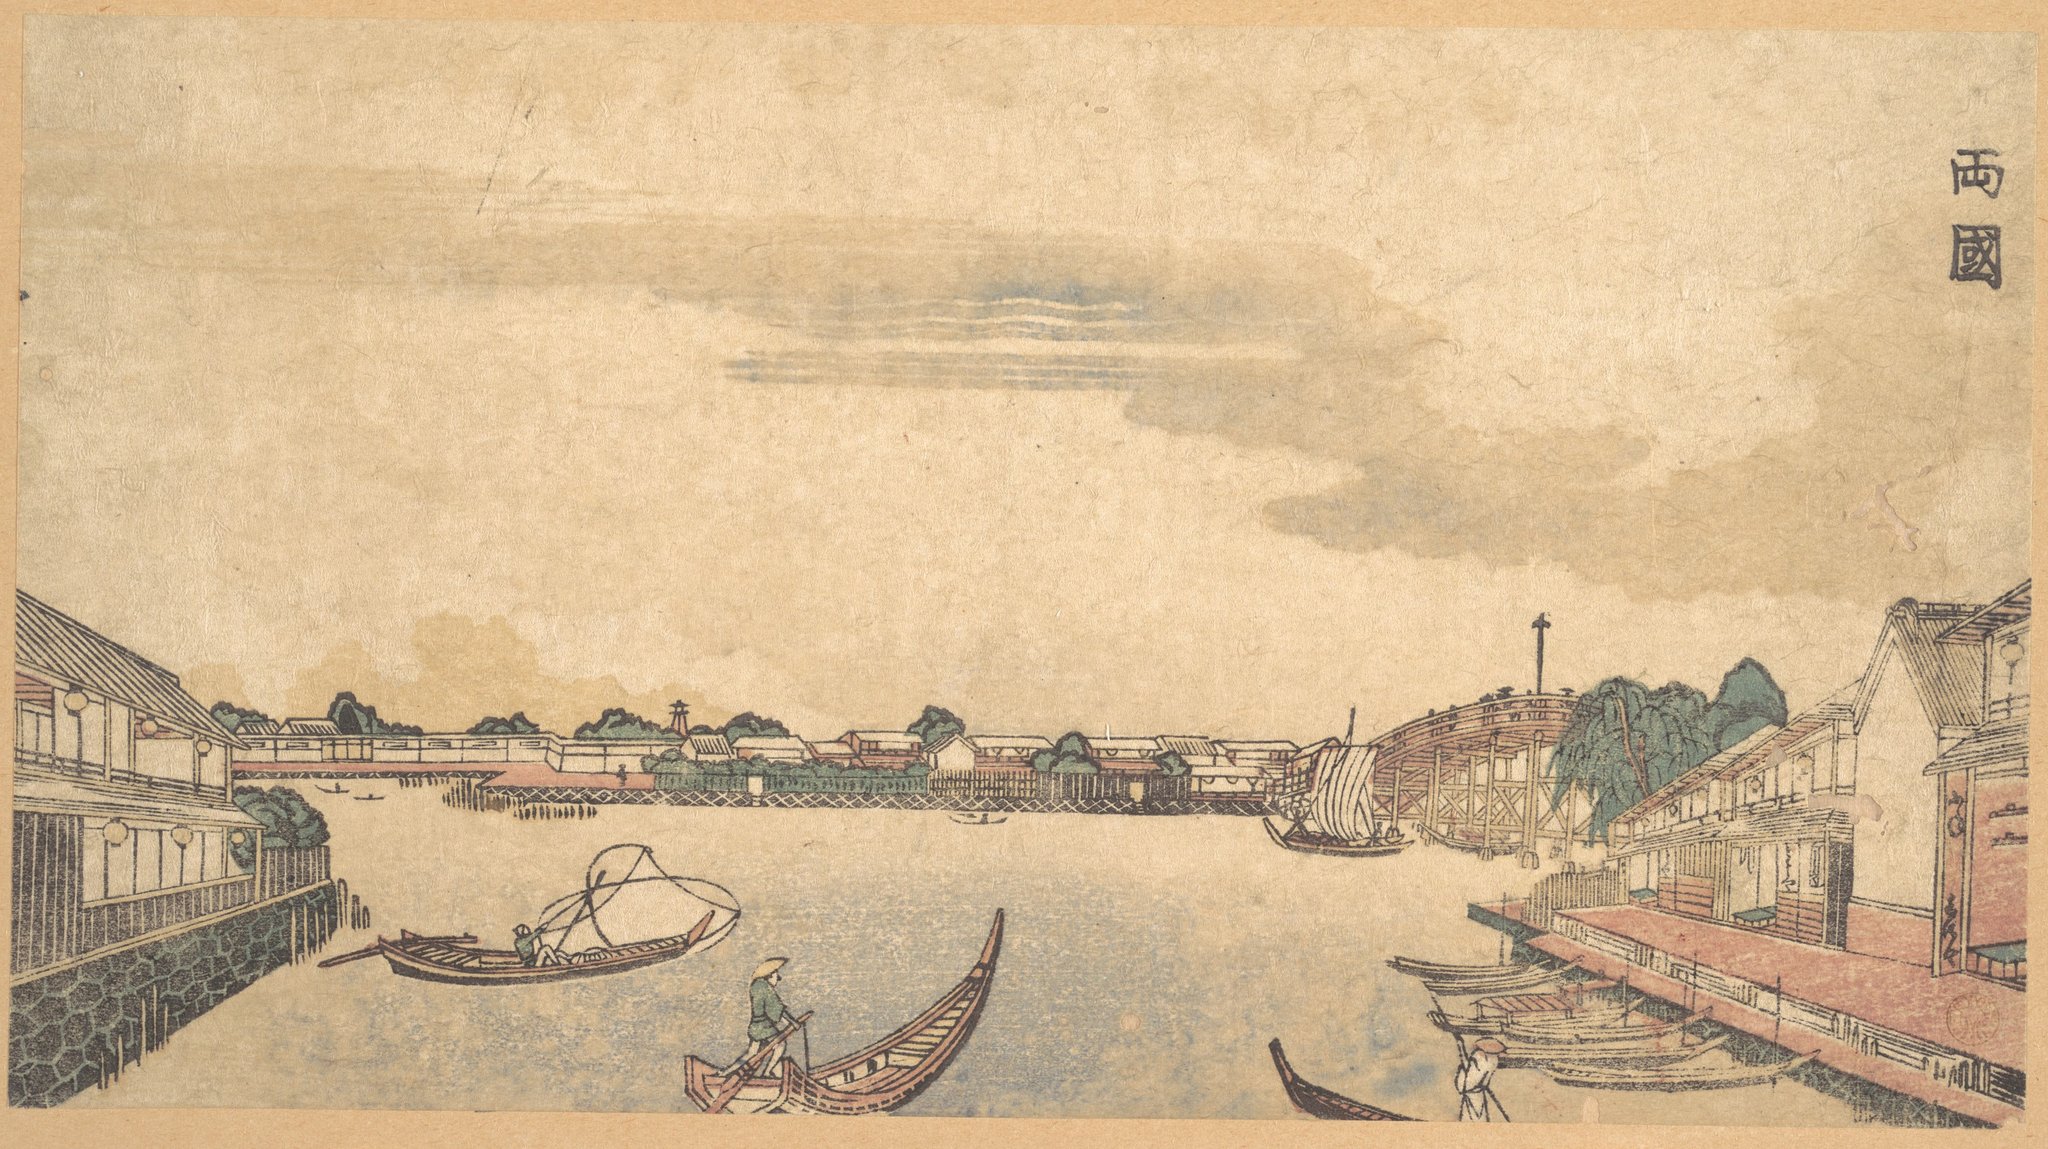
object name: print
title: Ryogoku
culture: japanese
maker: keisai eisen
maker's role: artist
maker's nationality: japanese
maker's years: 1790-1848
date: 1845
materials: ink, paper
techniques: woodblock print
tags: bridges,men,rivers,boats